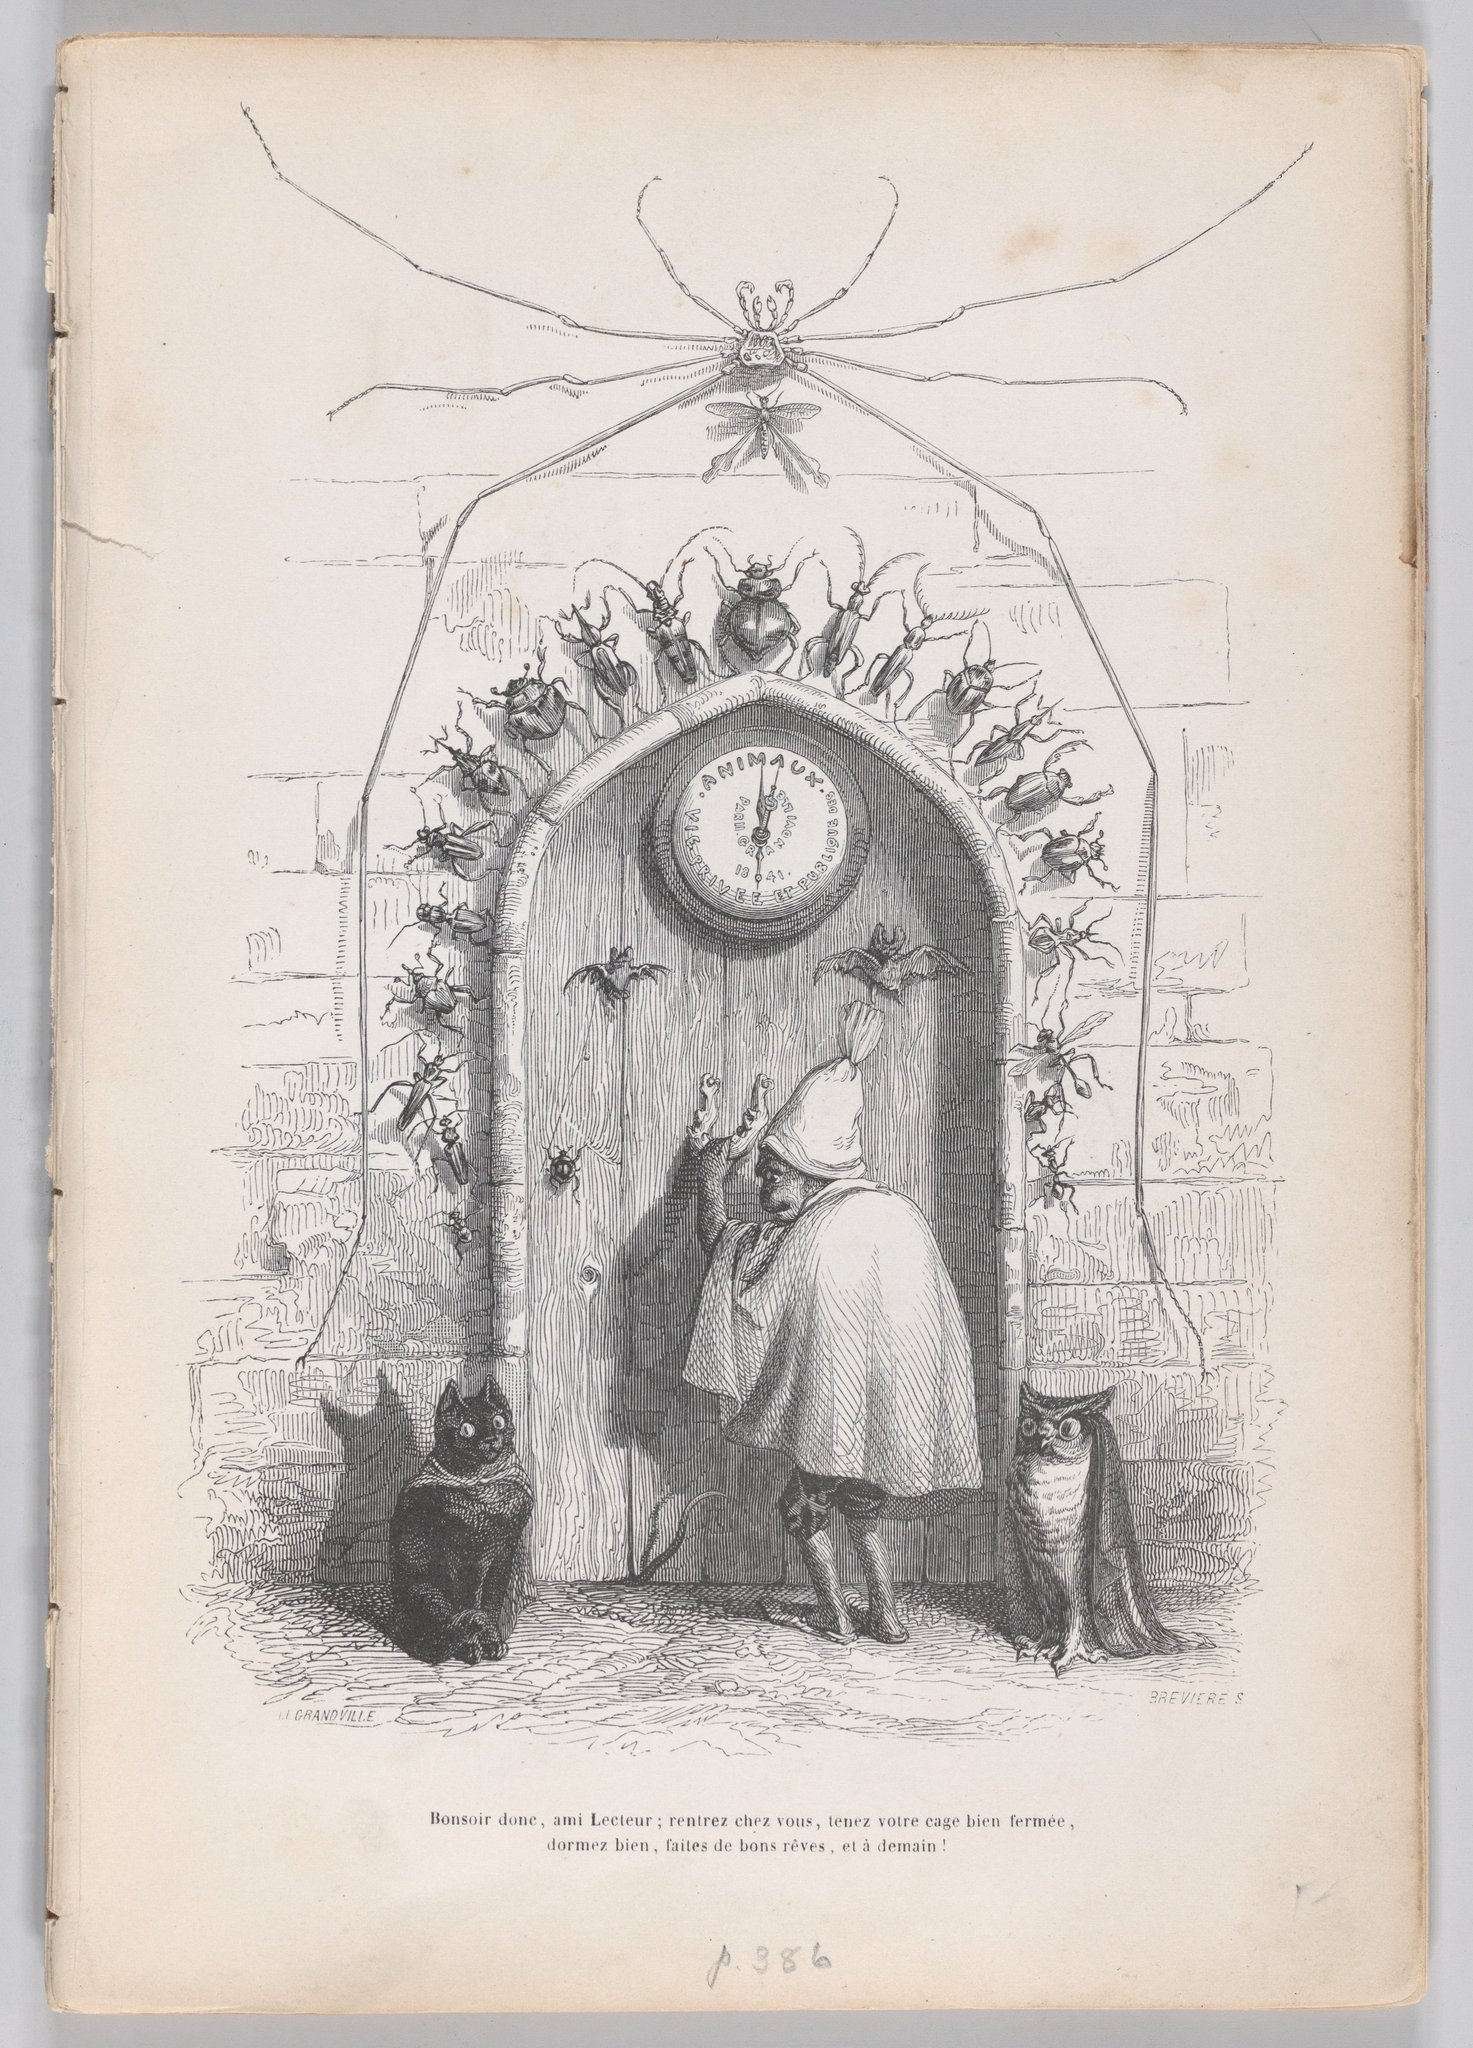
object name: print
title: Good evening then, my friend Lecteur..., from "Scenes from the Private and Public Life of Animals"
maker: j. j. grandville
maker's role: illustrator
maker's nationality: french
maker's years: 1803-1847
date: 1837-1847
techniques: engraving